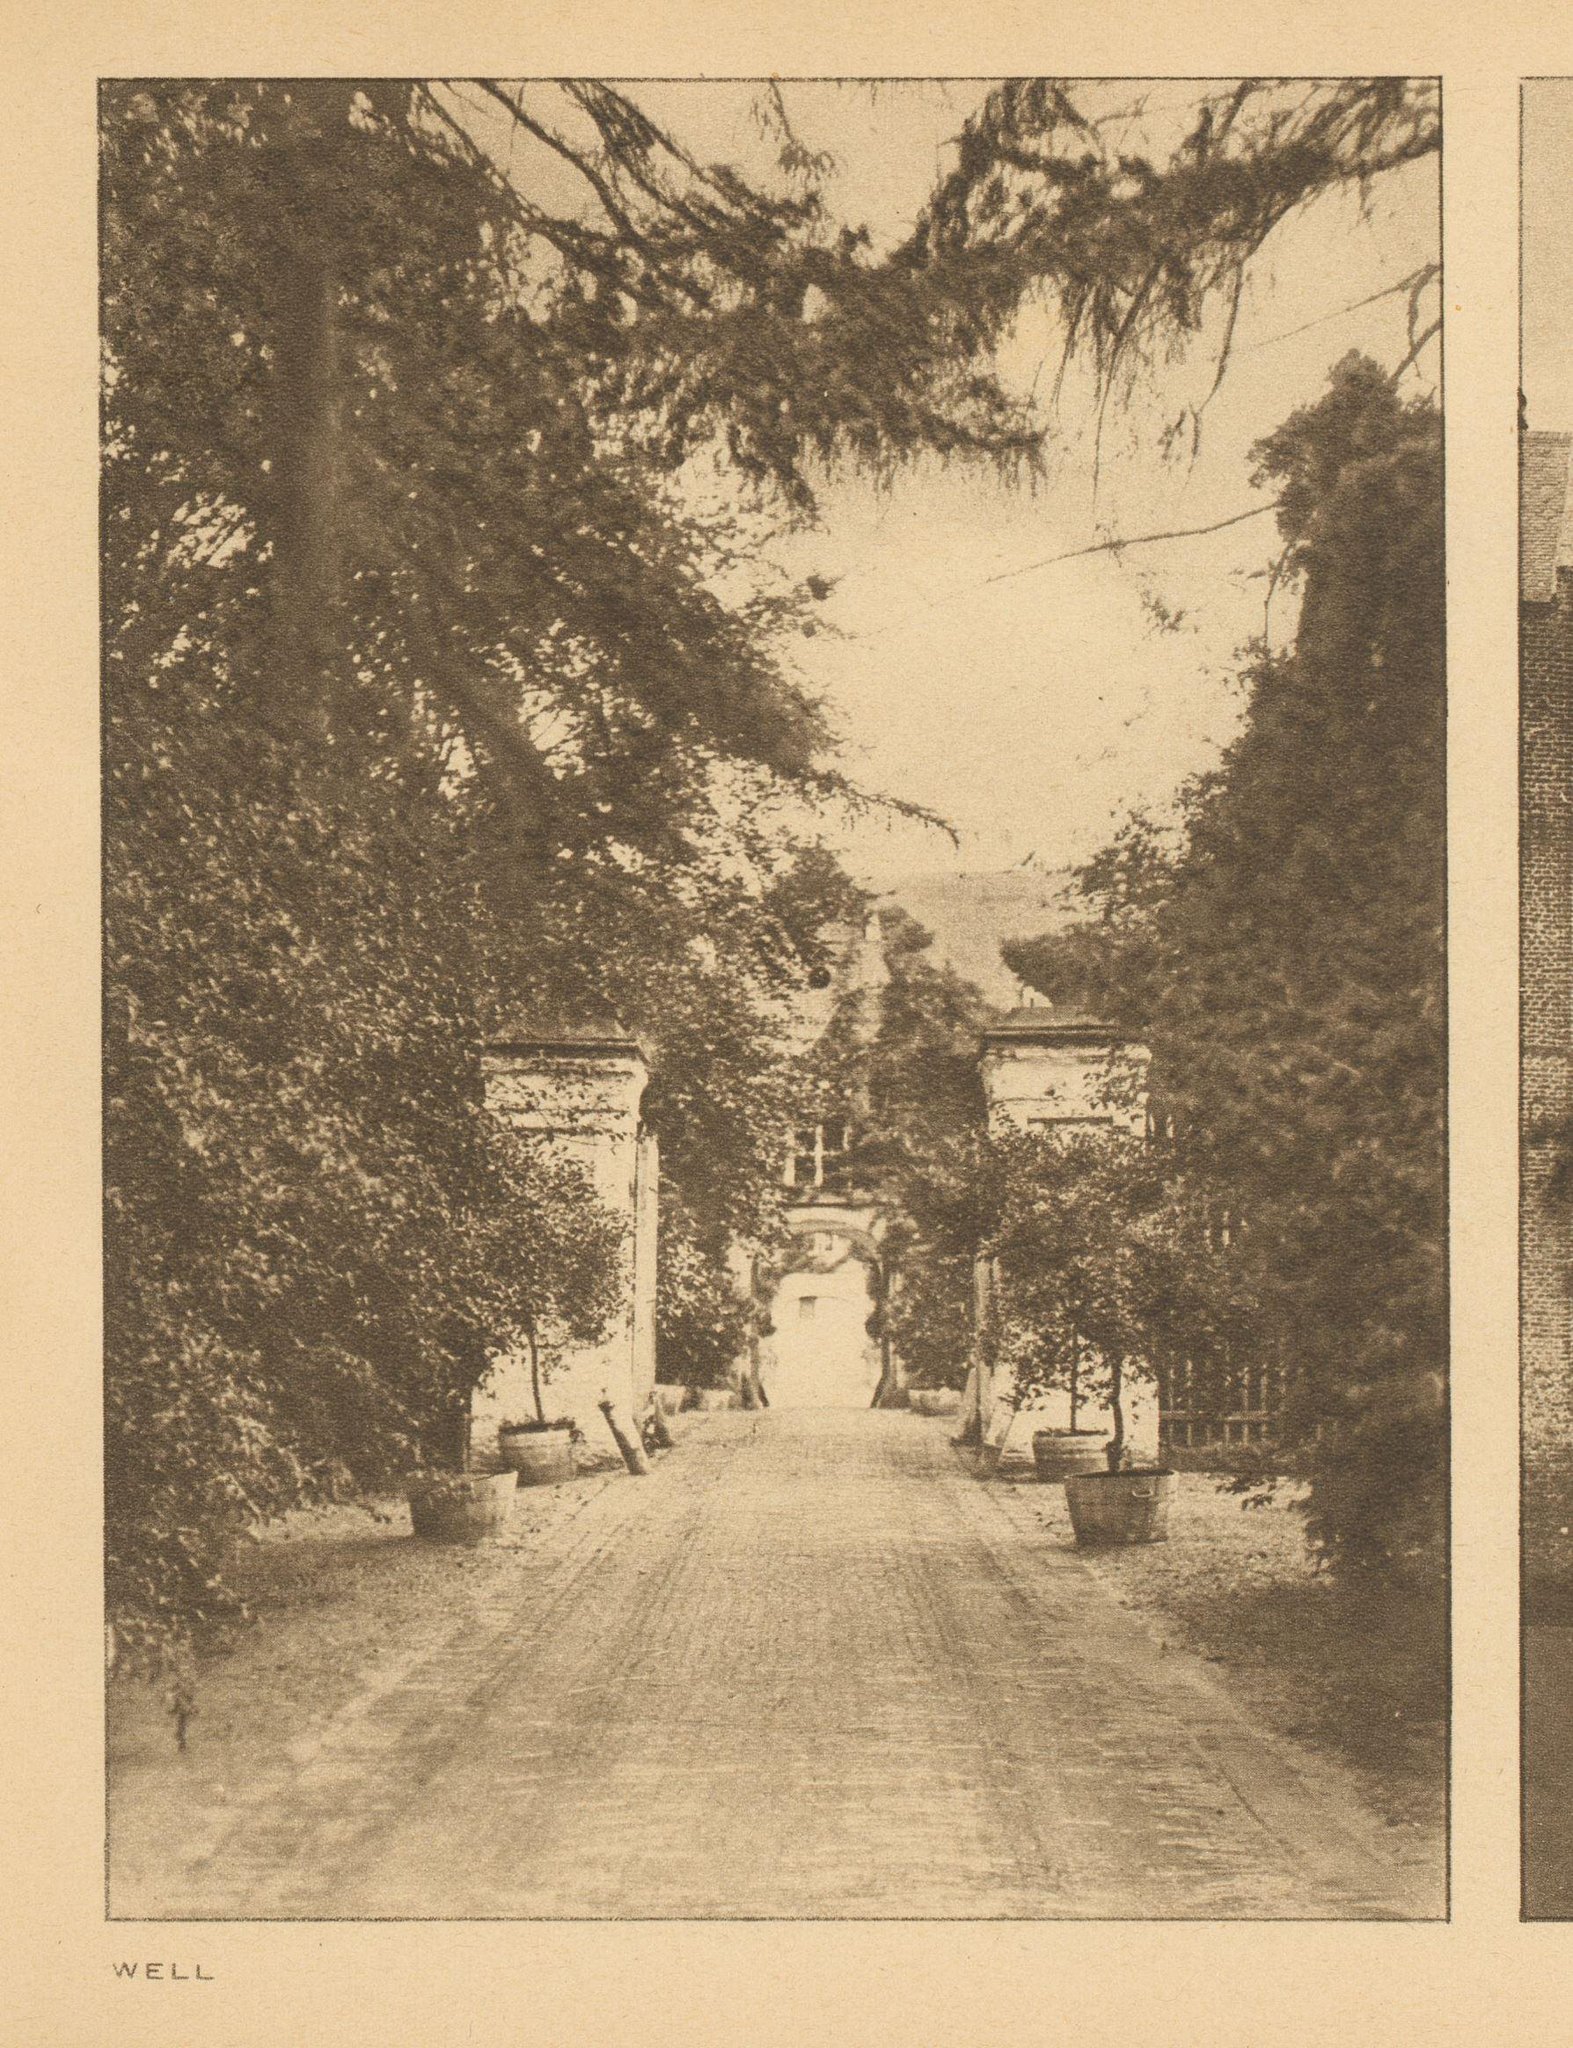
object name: album leaf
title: Well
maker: Anonymous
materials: paper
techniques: rotogravure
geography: well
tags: castle, gate, entrance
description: Deze prent maakt deel uit van een album.